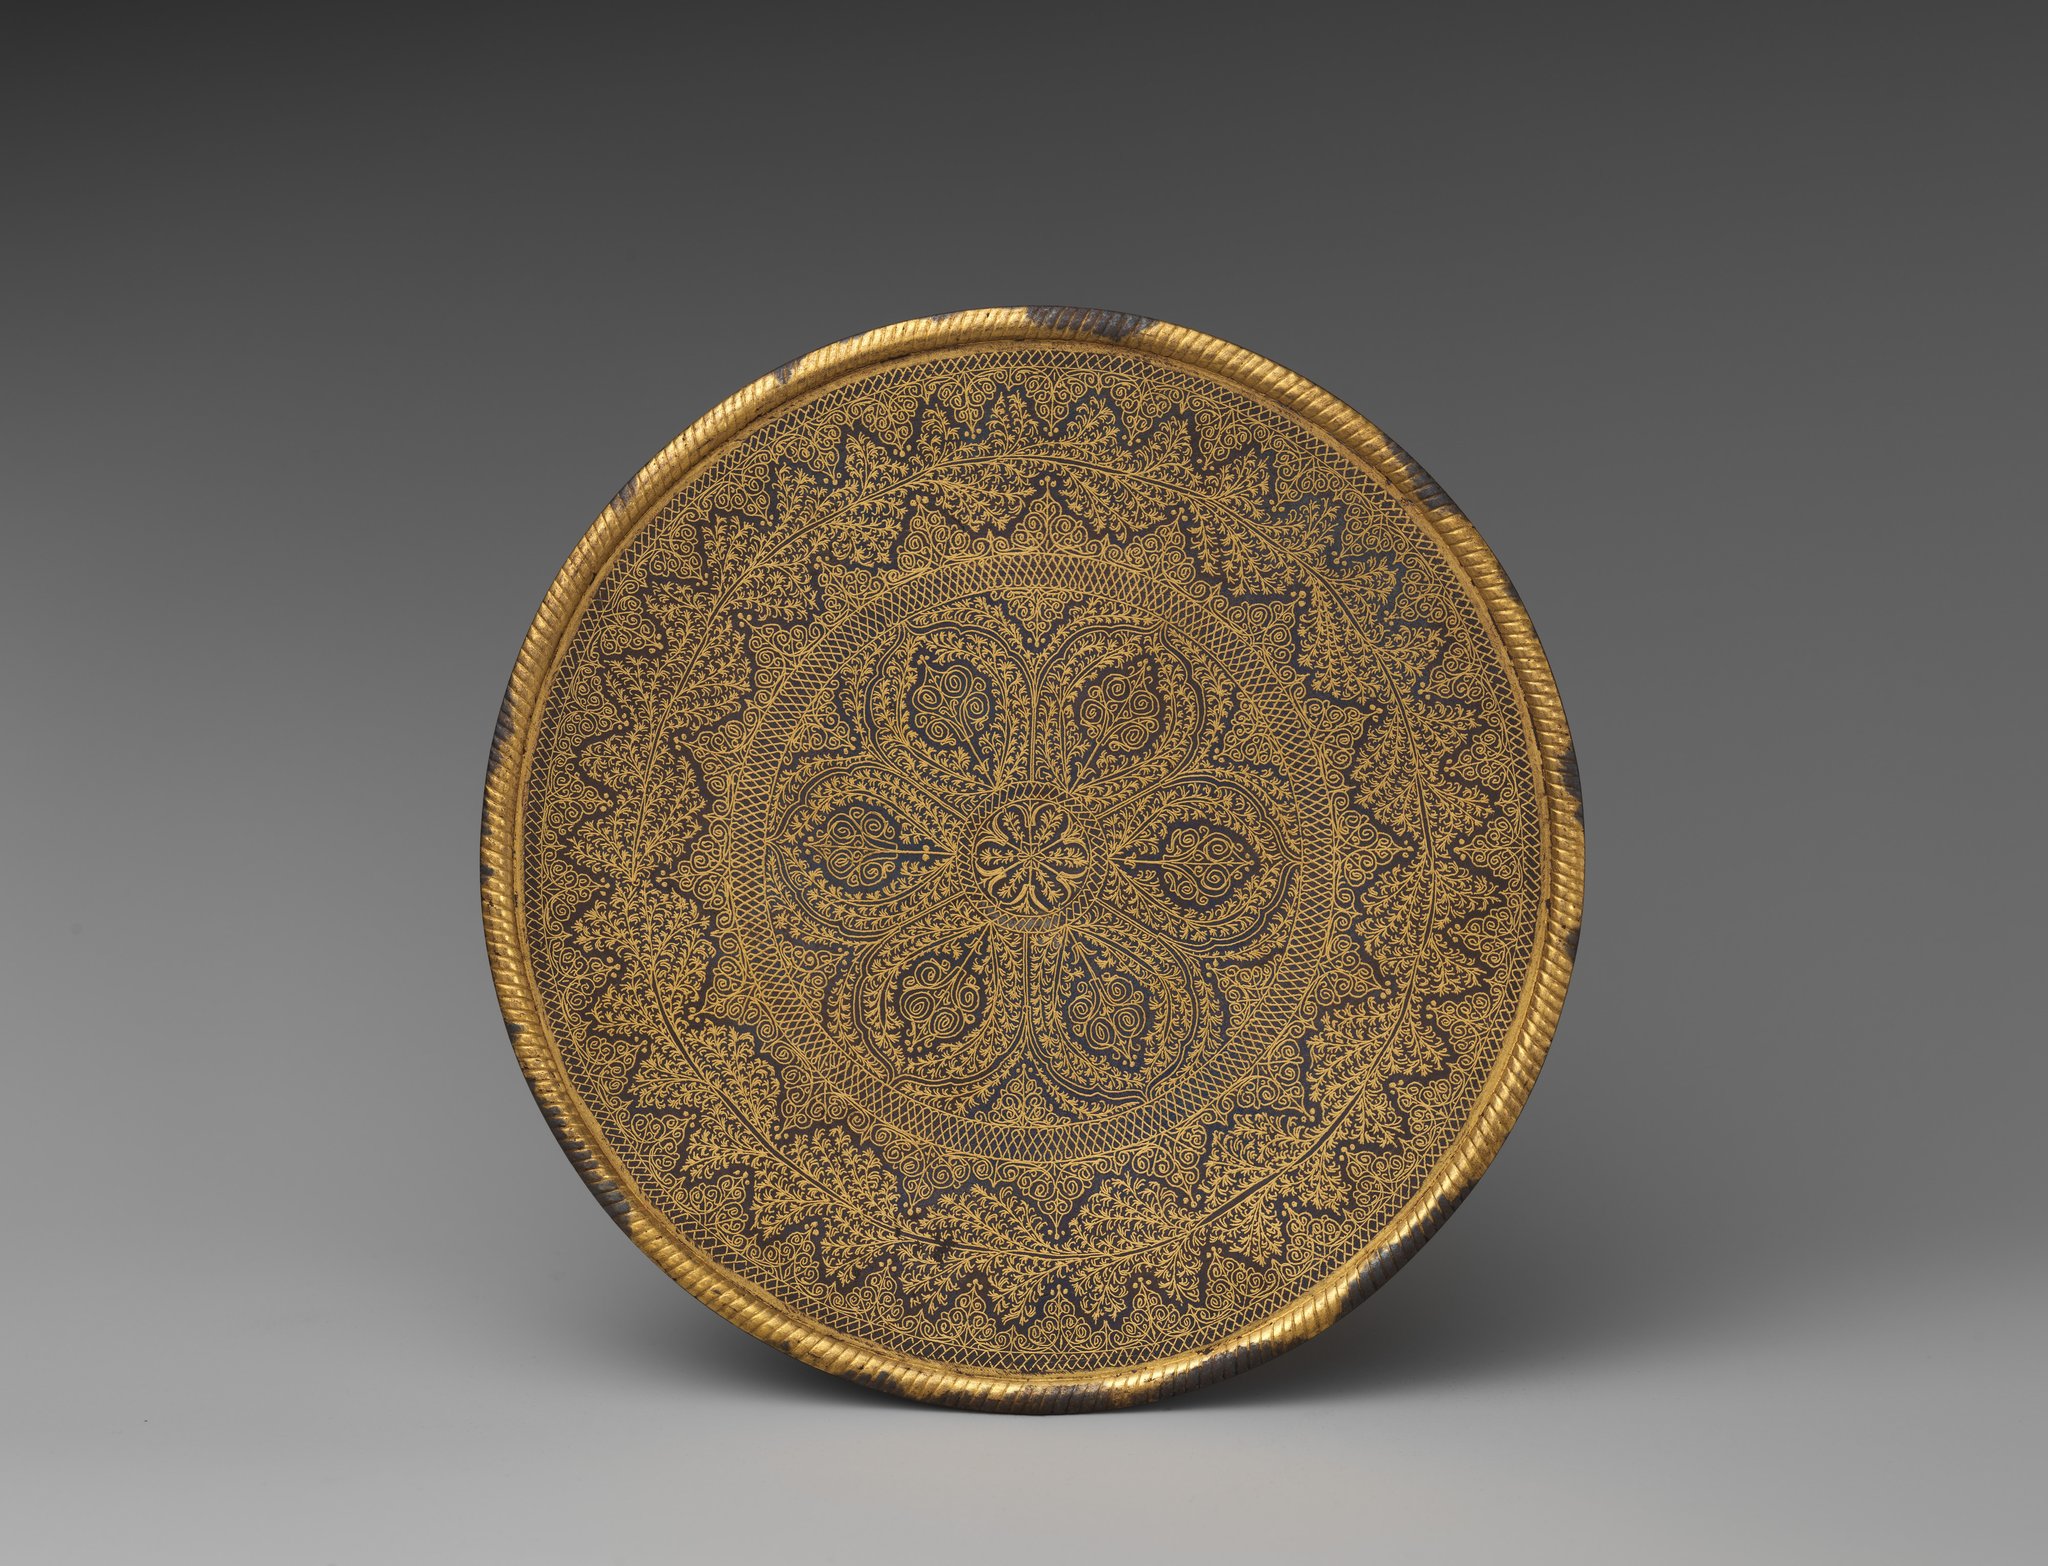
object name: card tray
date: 1801-1900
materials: gold, steel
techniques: inlay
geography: india